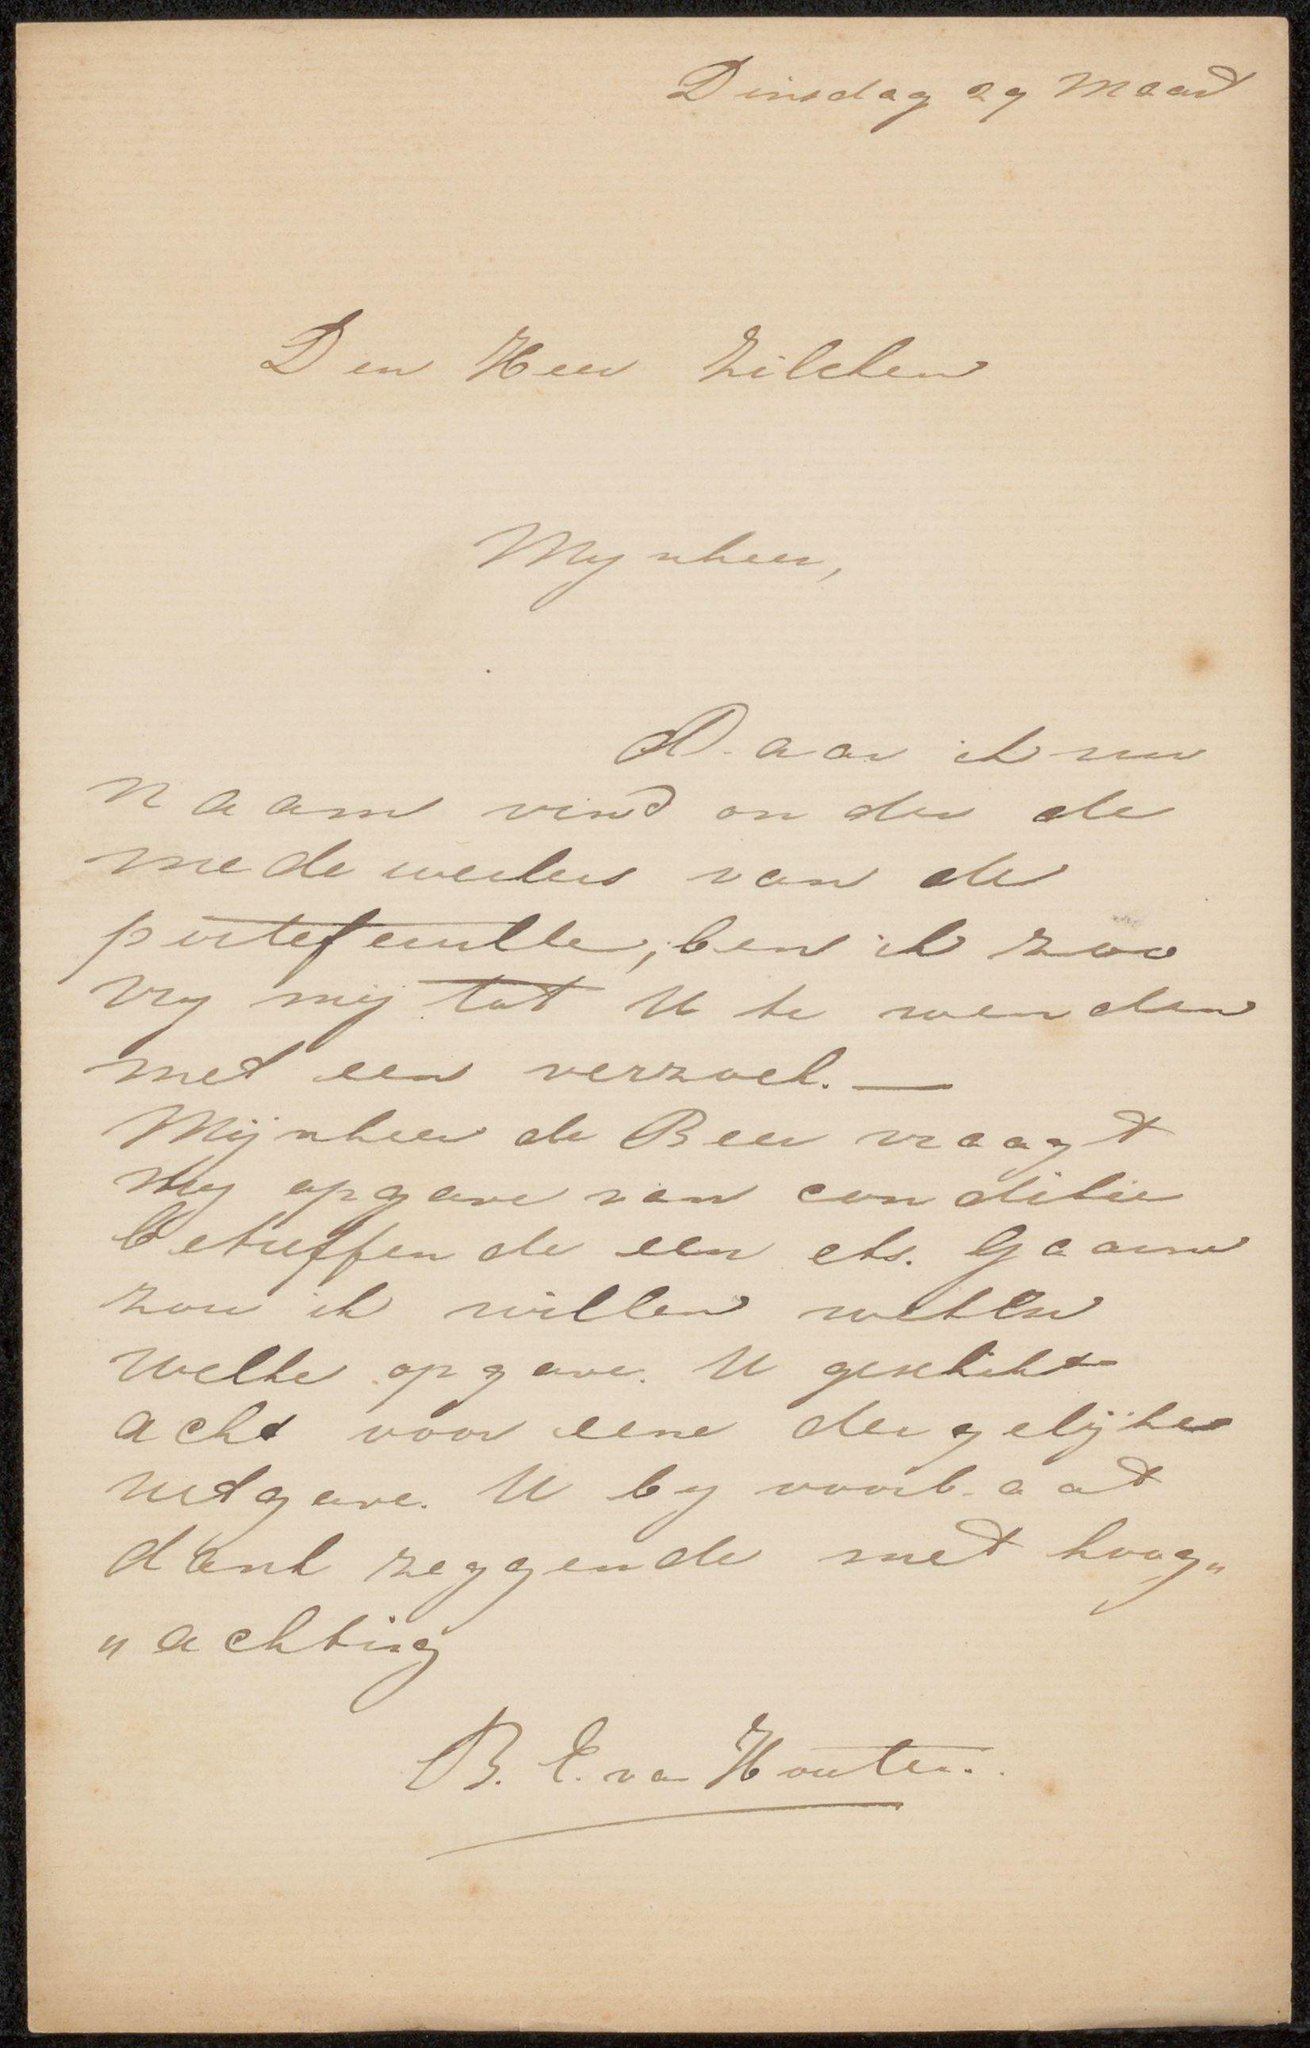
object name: letter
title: Brief aan Philip Zilcken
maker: barbara elisabeth van houten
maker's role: draughtsman, print maker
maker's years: 1862-1950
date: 1872-1930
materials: ink, paper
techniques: pen, writing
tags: painter, philip zilcken, the graphic arts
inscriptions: collector's mark: ‘RPK’